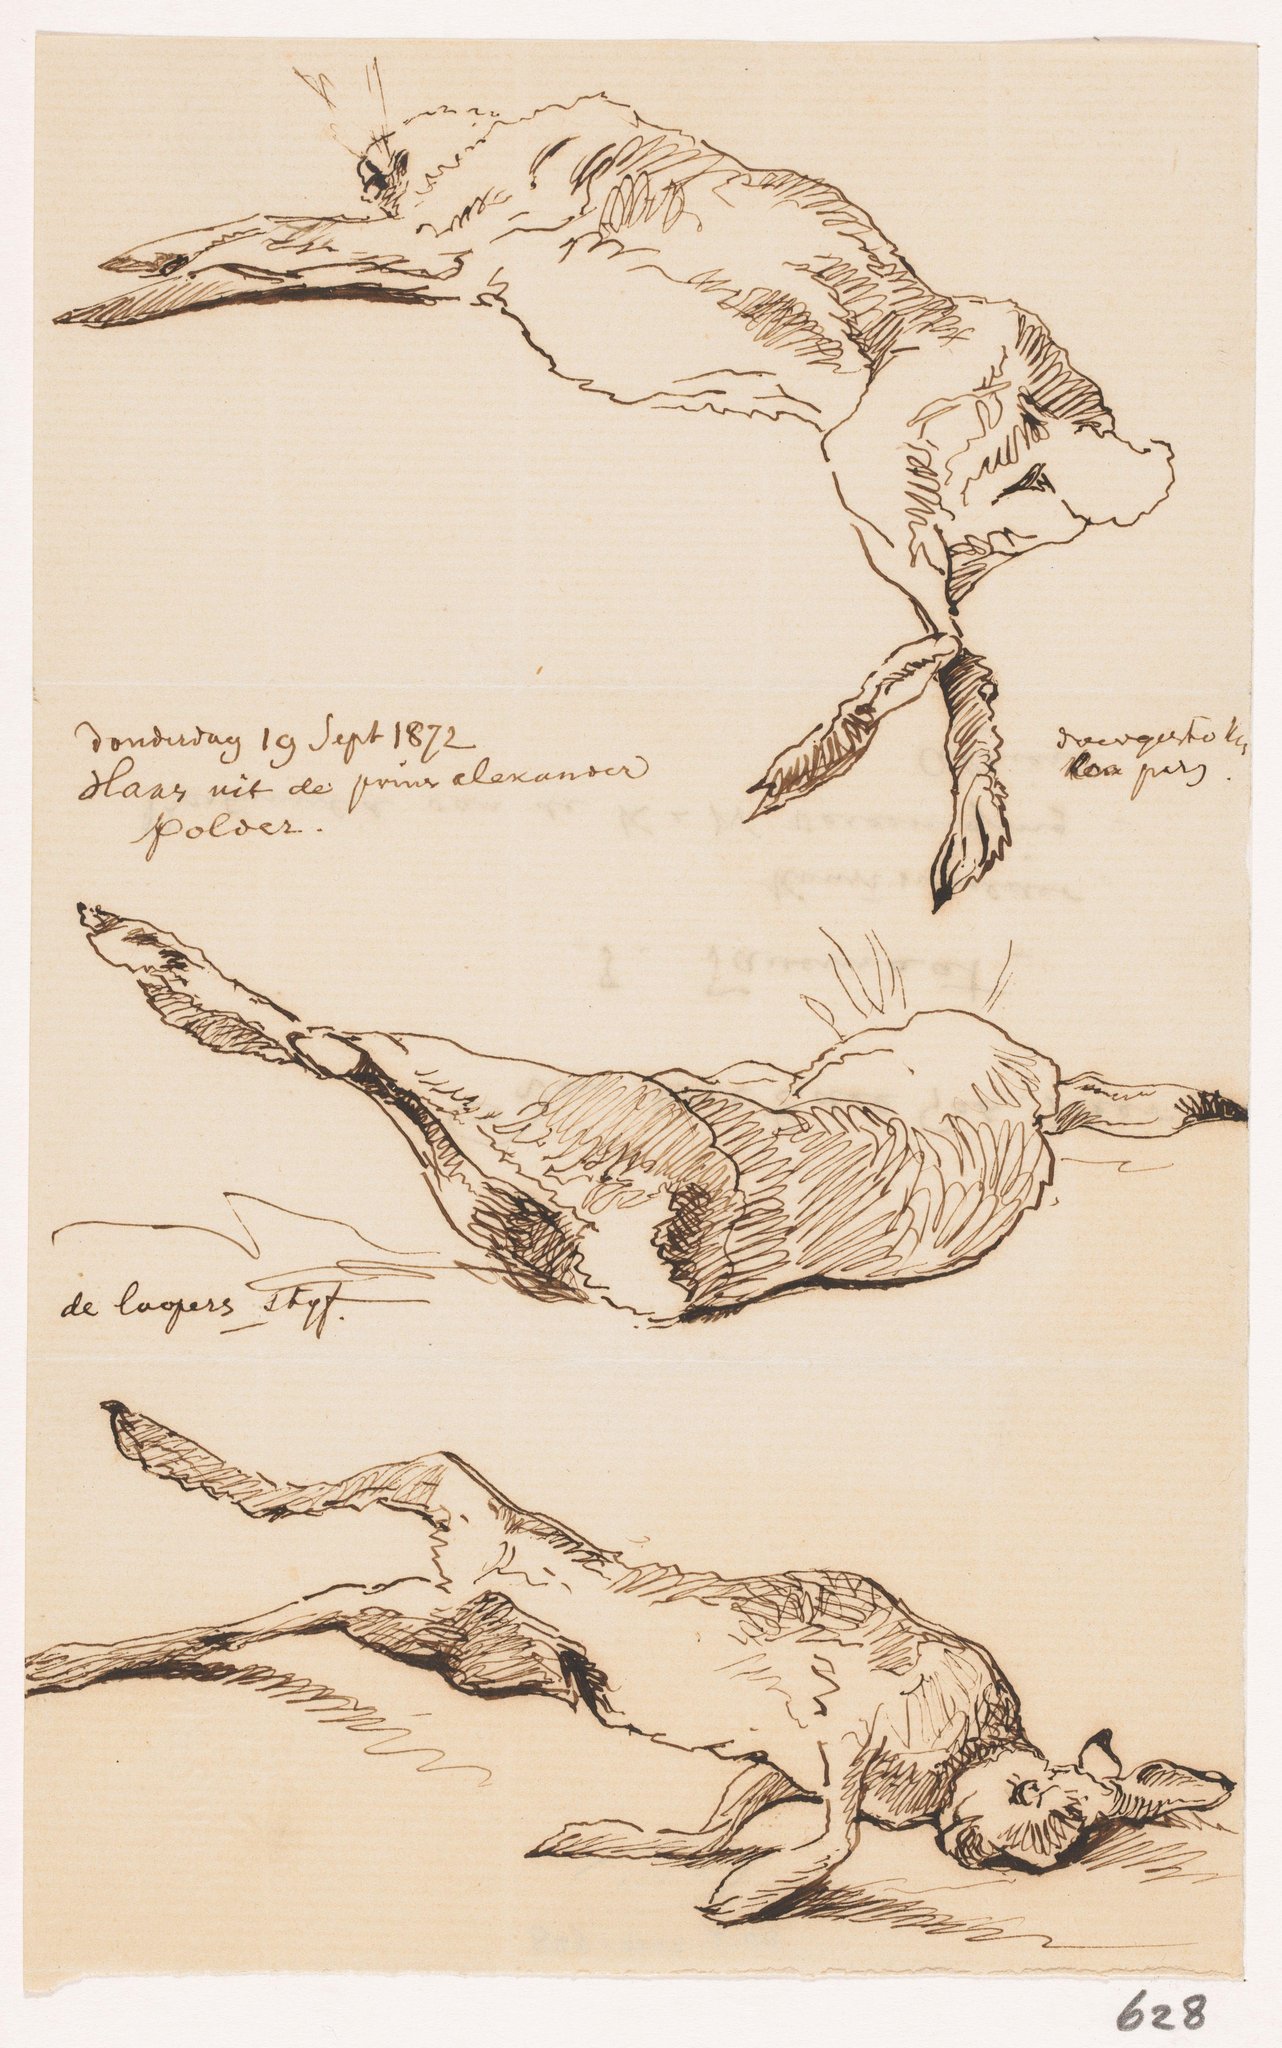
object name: drawing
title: Drie studies van een geschoten haas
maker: johannes tavenraat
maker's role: draughtsman, painter, print maker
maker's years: 1809-1881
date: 1872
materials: ink, paper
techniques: pen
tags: rodents (with name) (+ dying animal; death of animal; dead animal)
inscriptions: collector's mark: Lugt 2228, annotation: ‘donderdag 19 Sept 1872 / Haas uit de prins alexander polder / ... loopers / de loopers stijf’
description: Drie studies van een haas, geschoten in de Prins Alexanderpolder in 1872. Getekend op de achterzijde van een envelop of brief gericht aan J. Tavenraat.